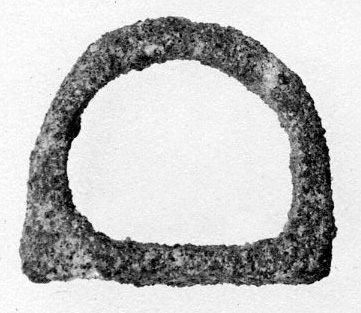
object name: ring, finger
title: Ring with a flat bezel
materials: copper alloy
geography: egypt